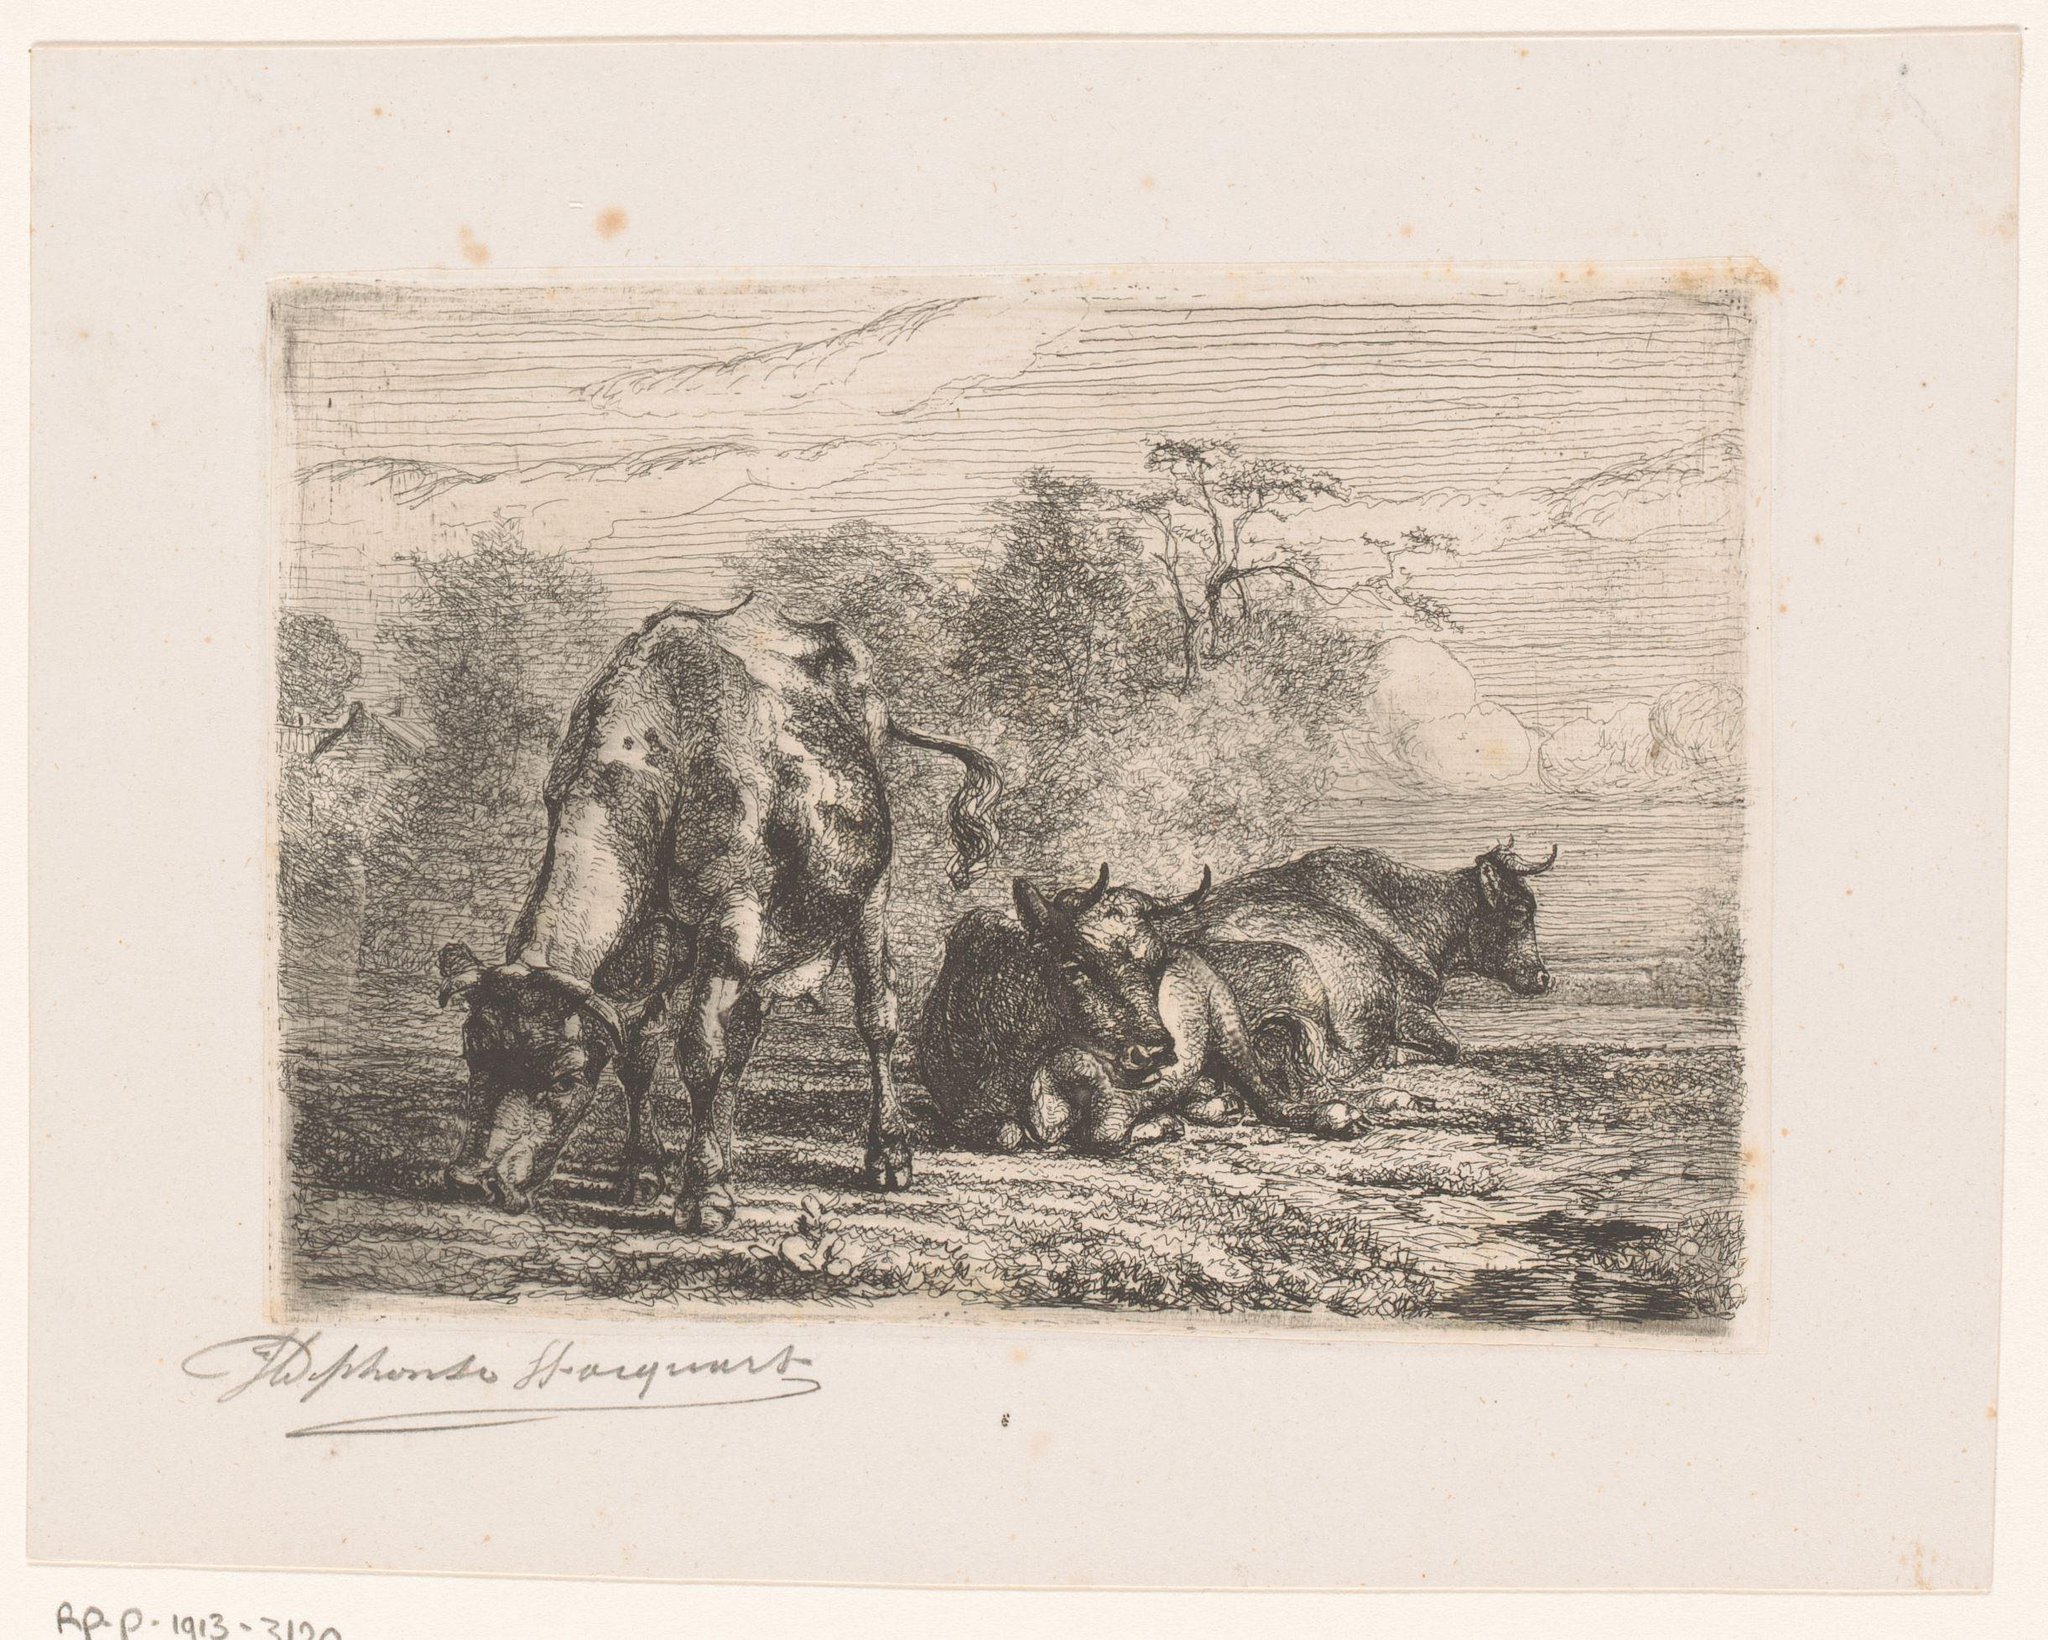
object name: print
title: Landschap met drie koeien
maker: ildephonse stocquart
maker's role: print maker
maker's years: 1819-1889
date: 1829-1879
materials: paper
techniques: etching, intaglio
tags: cow, meadow, pasture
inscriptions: collector's mark: Lugt 2228